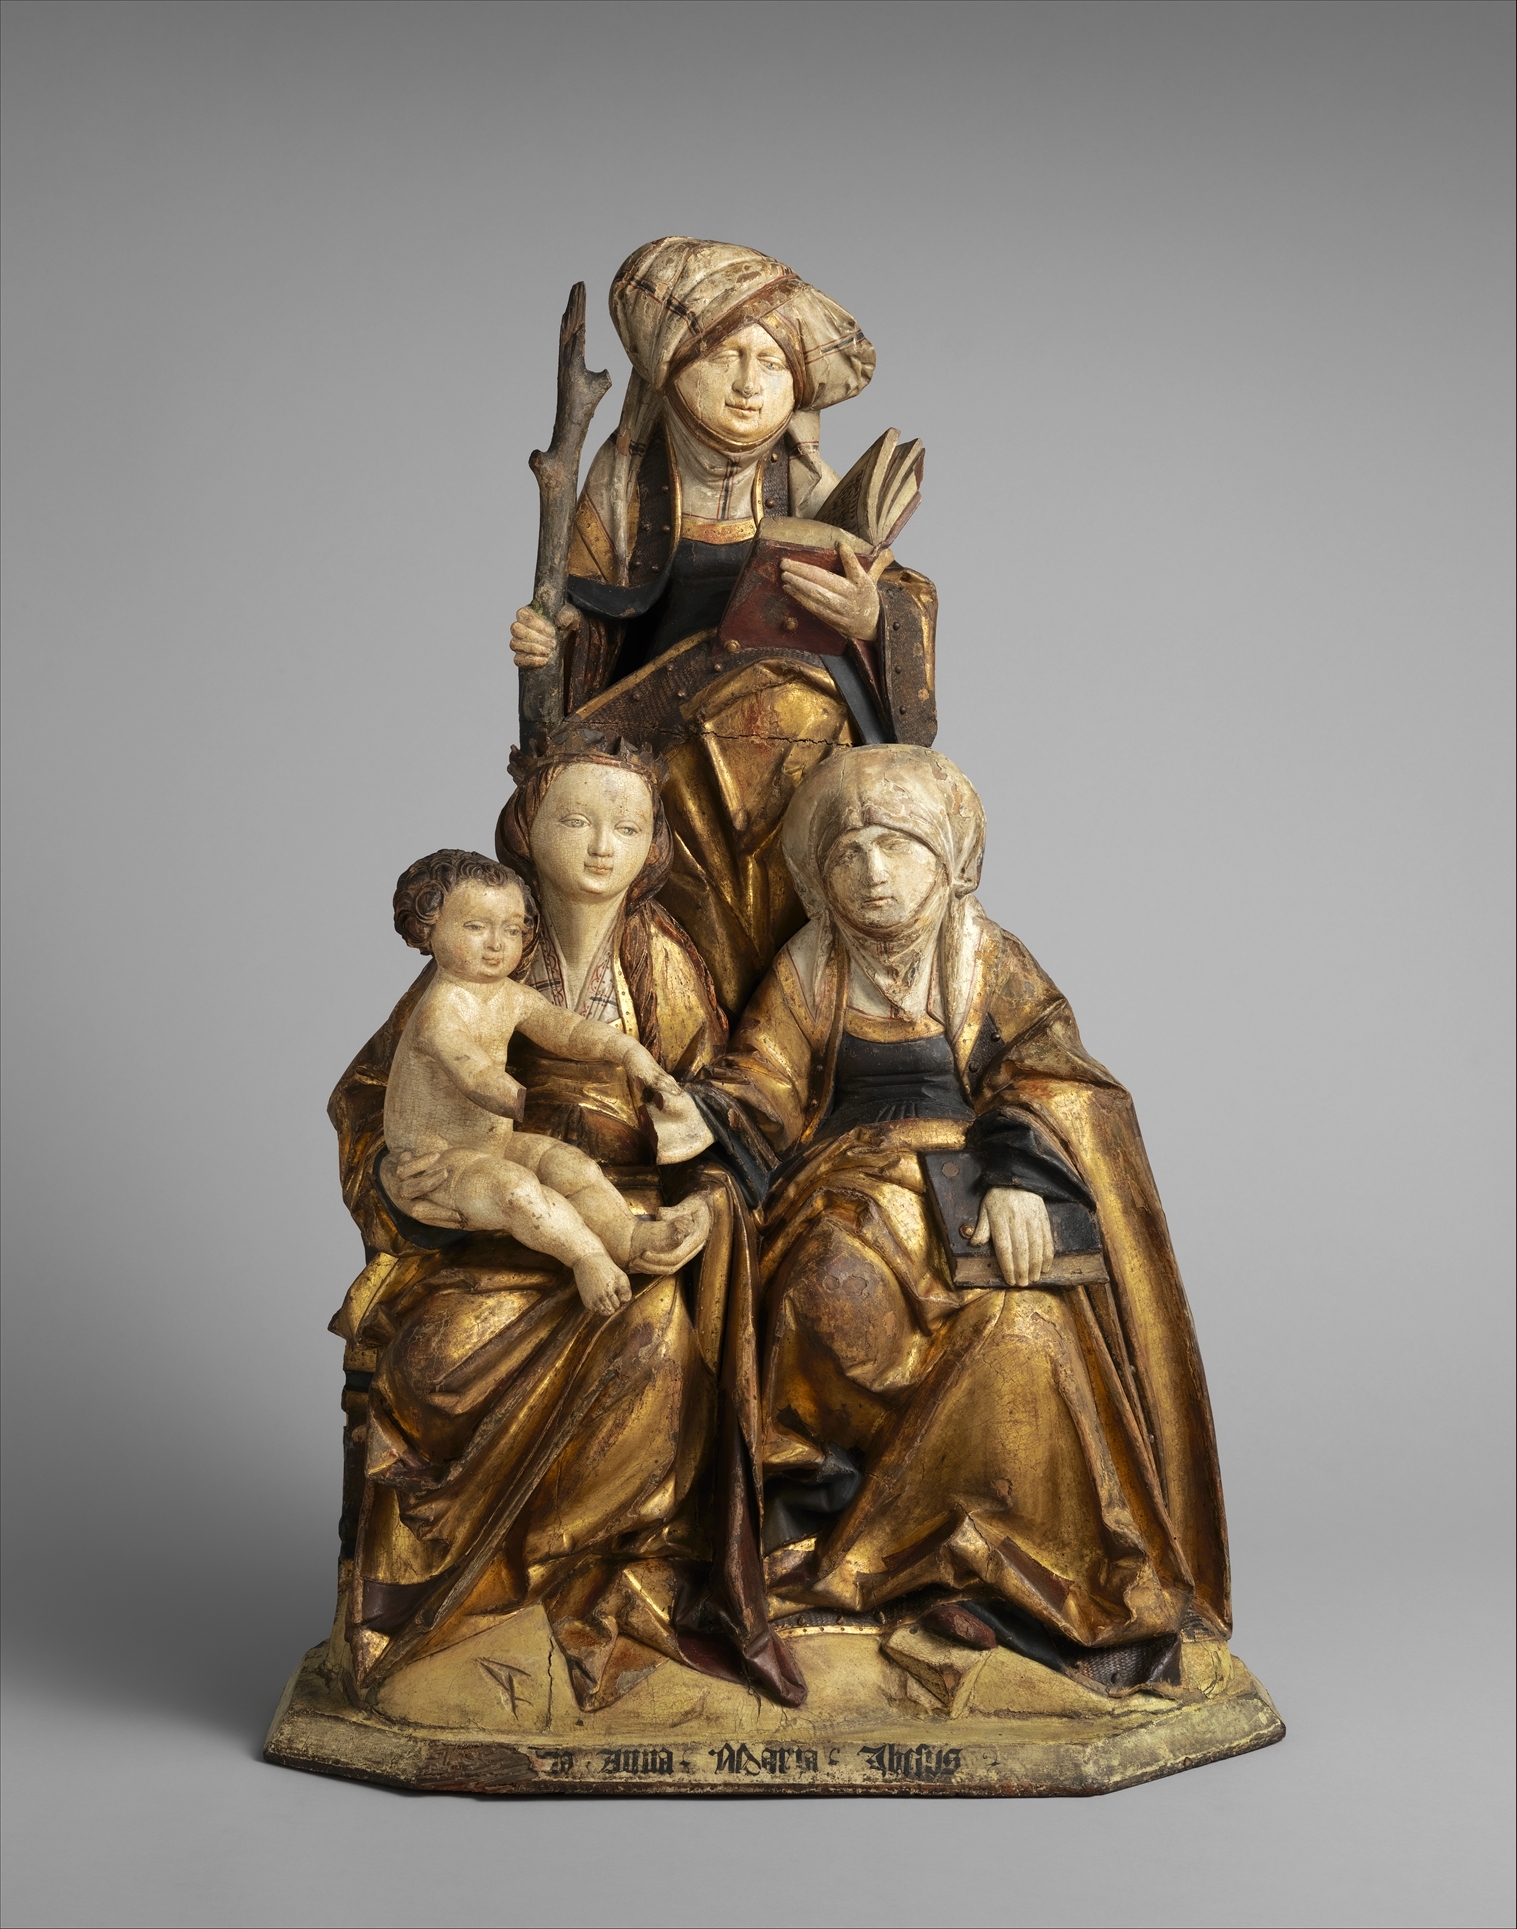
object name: statuette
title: The Virgin and Child, Saint Anne, and Saint Emerentia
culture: german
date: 1515-1530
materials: paint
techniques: gilding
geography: germany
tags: saint anne,saints